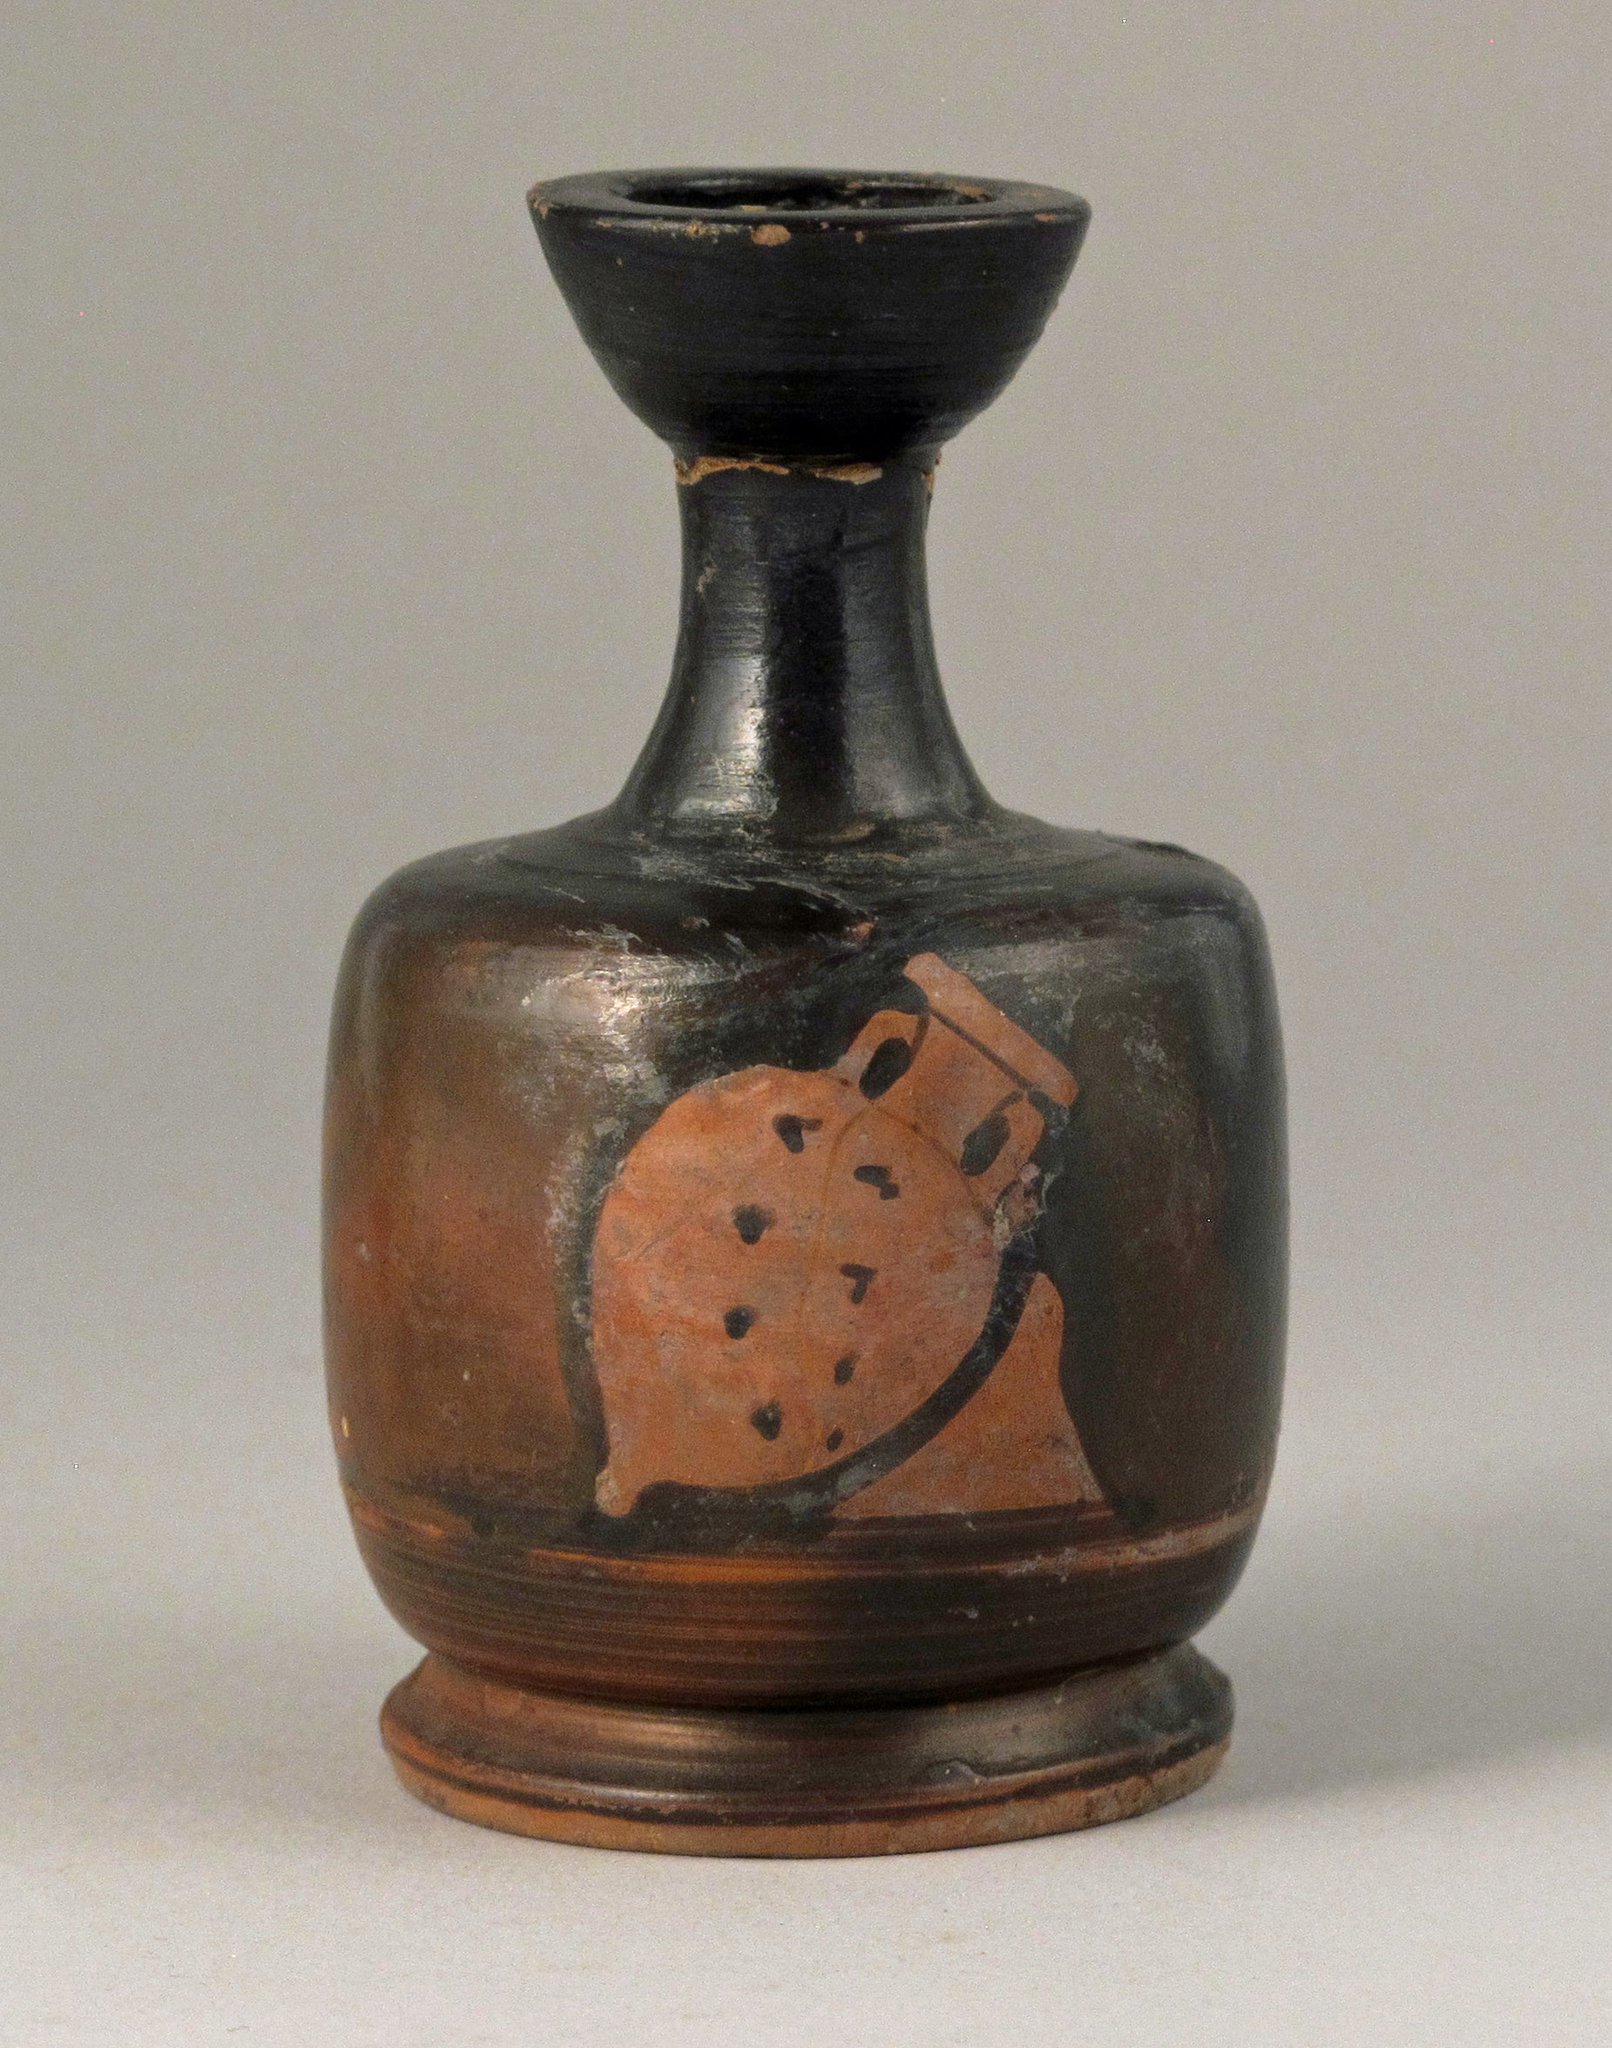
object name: squat lekythos, miniature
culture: greek, attic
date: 425-400 BCE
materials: terracotta